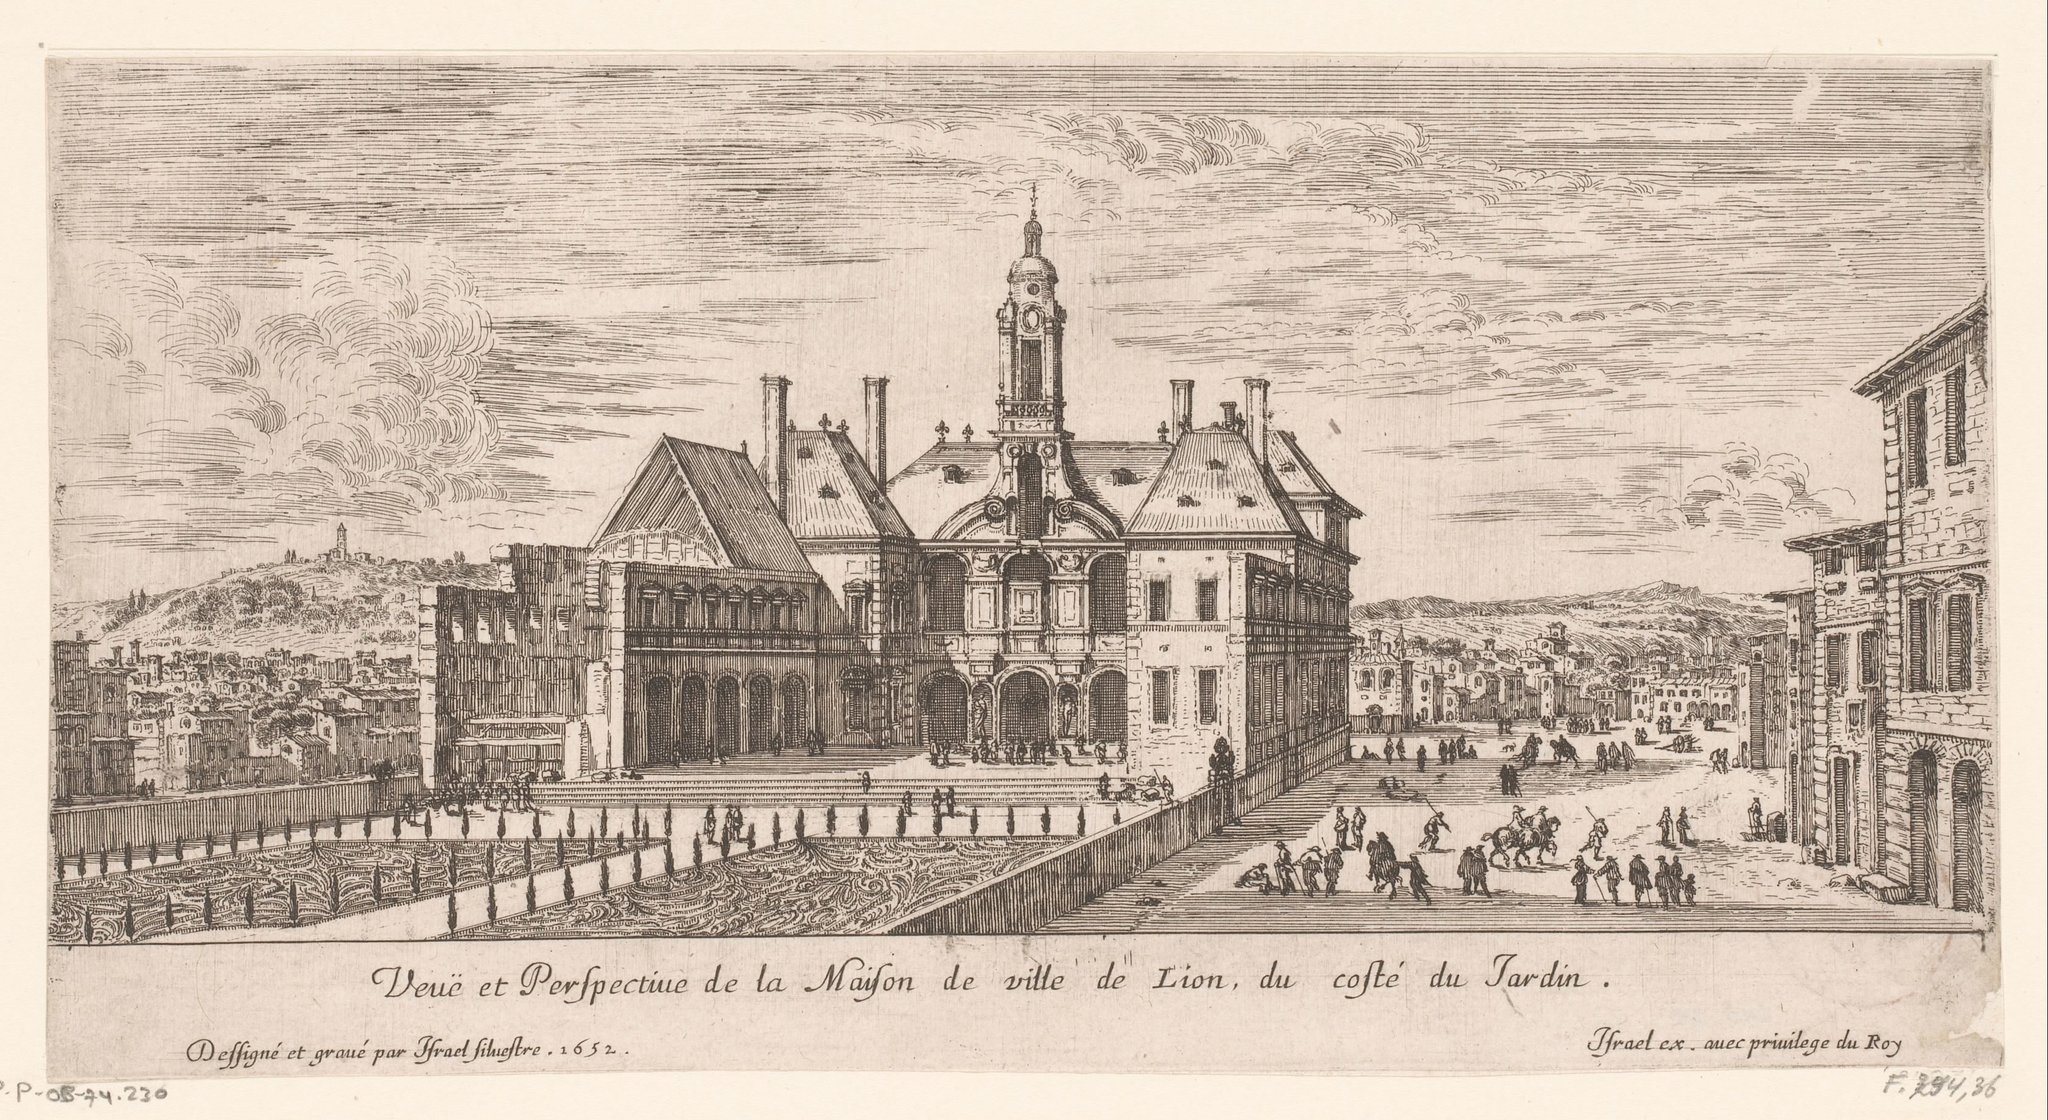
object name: print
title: Gezicht op het stadhuis van Lyon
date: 1652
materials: paper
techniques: engraving, etching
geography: france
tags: city-view, and landscape with man-made constructions, french or architectonic garden; formal garden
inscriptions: collector's mark: Lugt 240